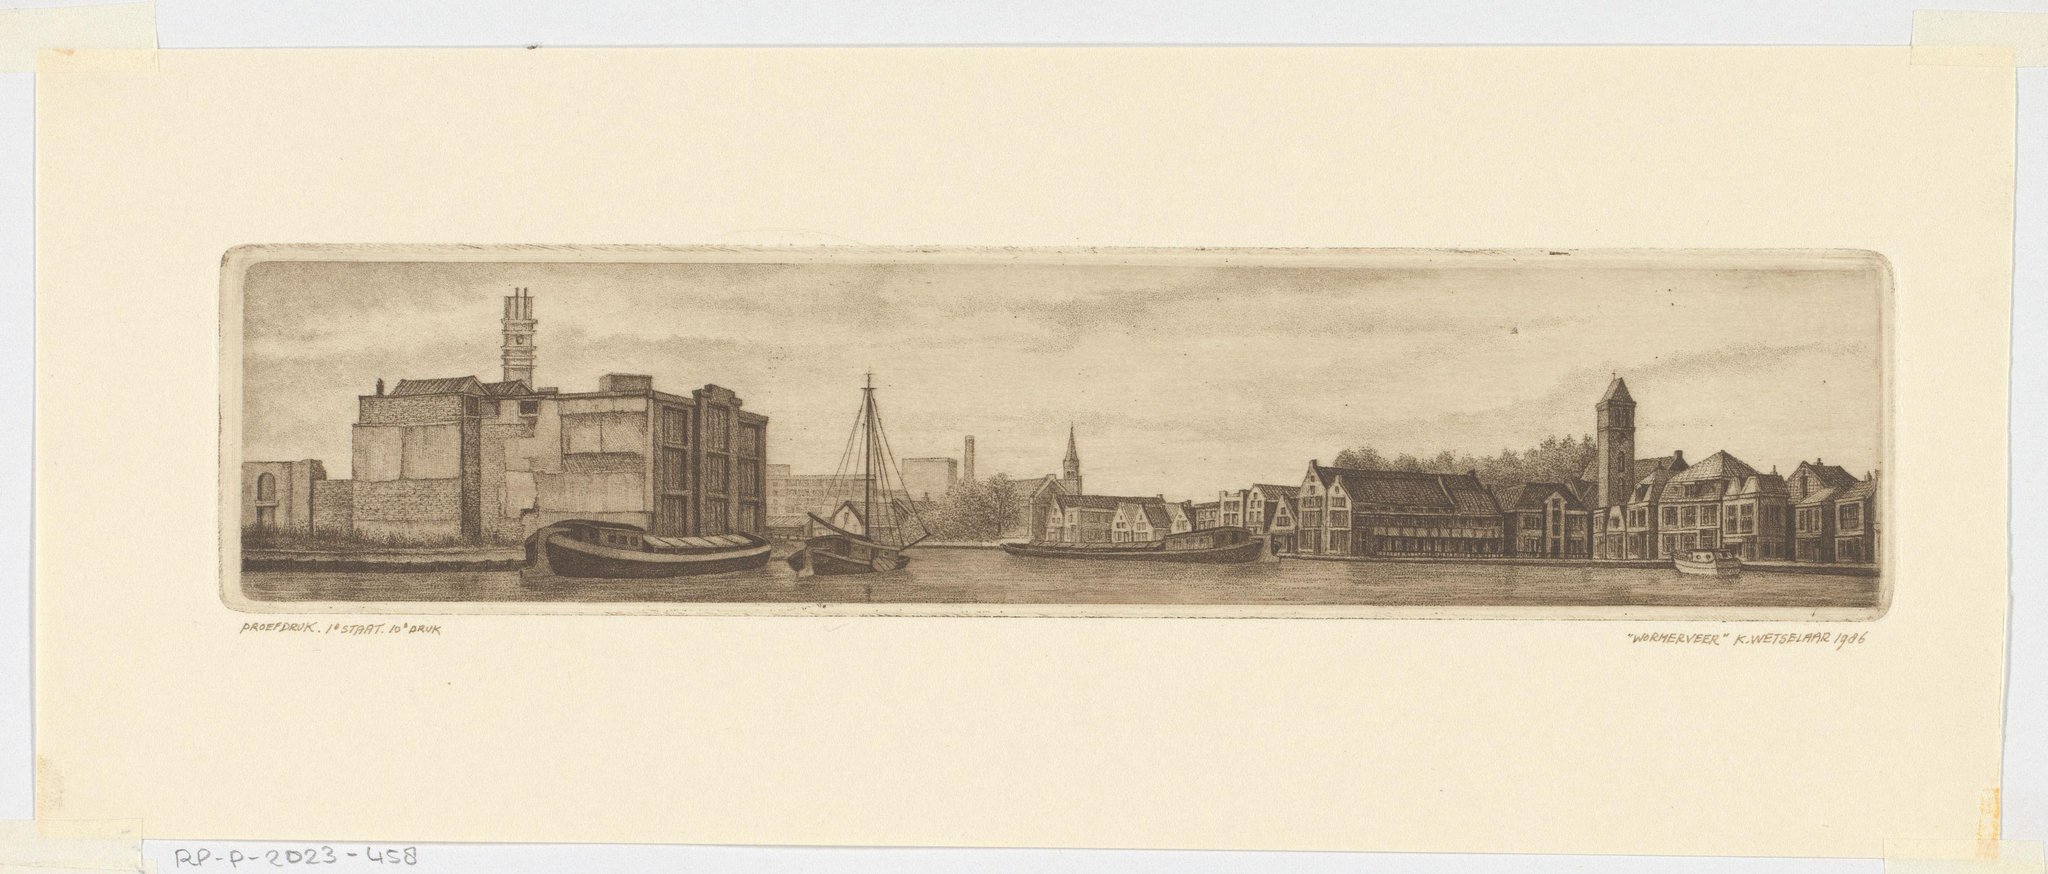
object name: print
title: Wormerveer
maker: karel wetselaar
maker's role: print maker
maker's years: 1935-2017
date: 1986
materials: paper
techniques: aquatint, etching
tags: canals, waters (in village), village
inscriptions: inscription: ‘proedruk. 1e staat. 10e druk’, signature and date: ‘K. Wetselaar 1986’